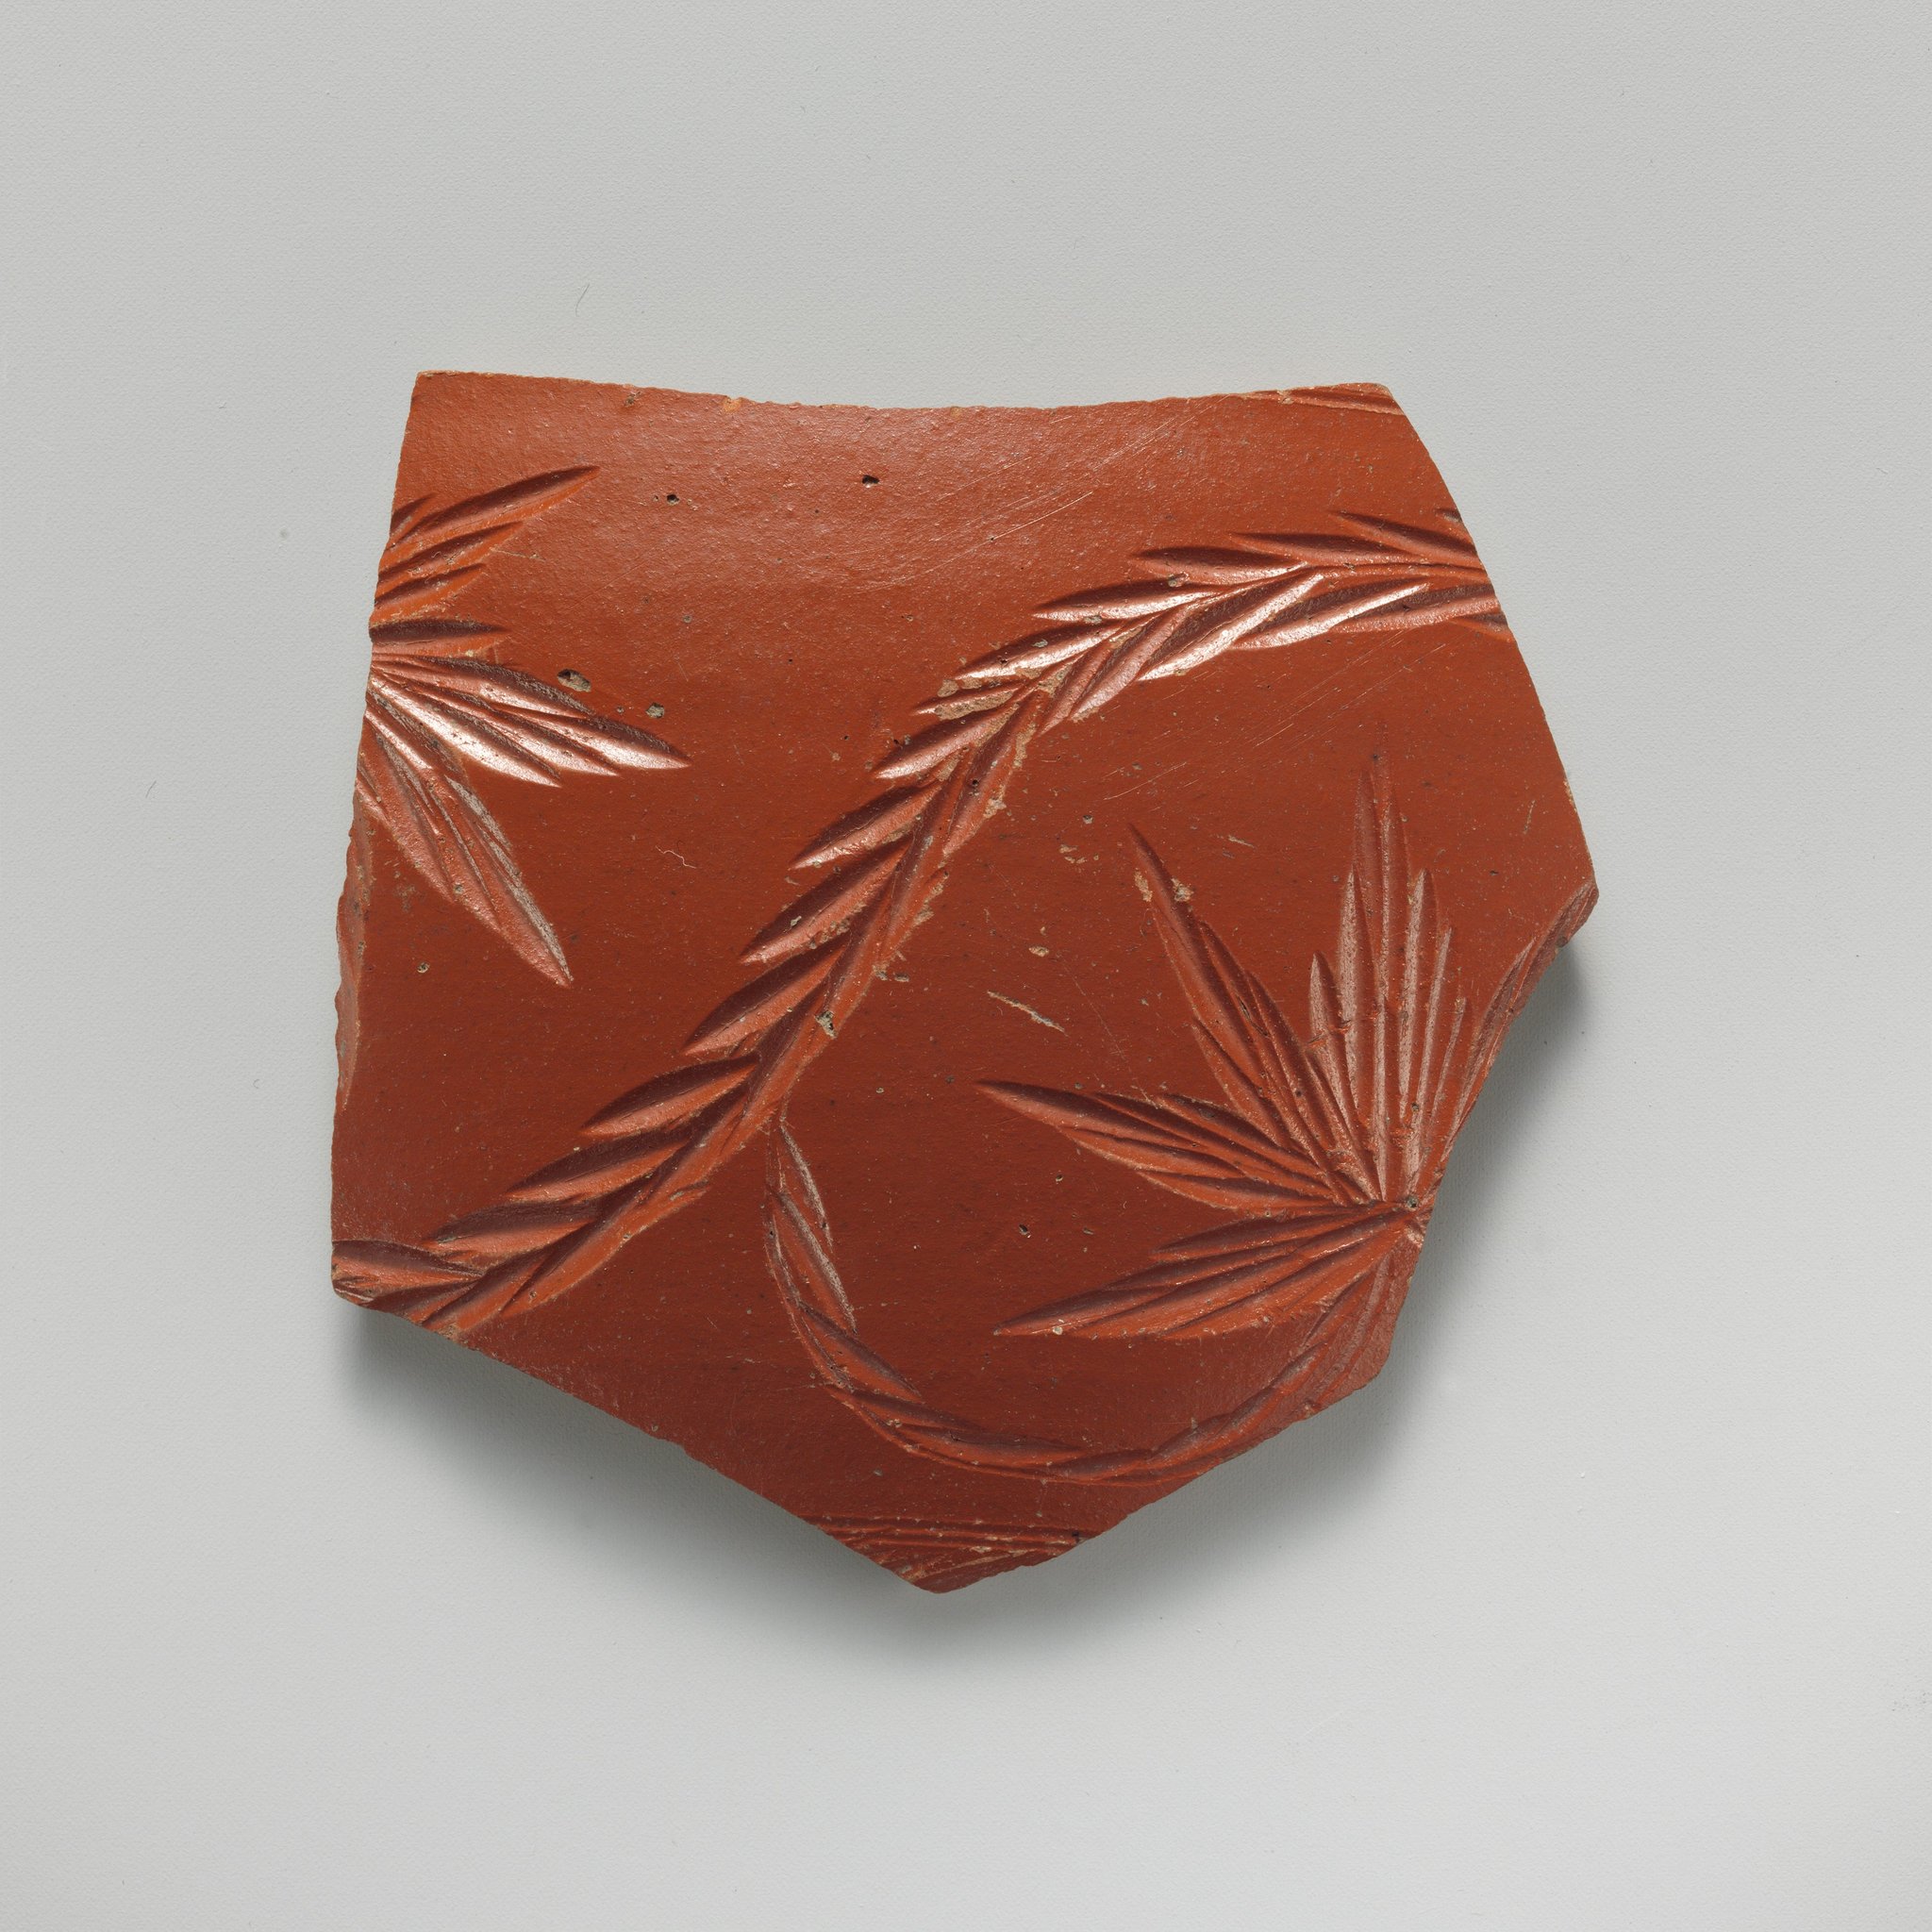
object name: vase fragment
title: Fragment of terra sigillata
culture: roman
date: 170-220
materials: terracotta